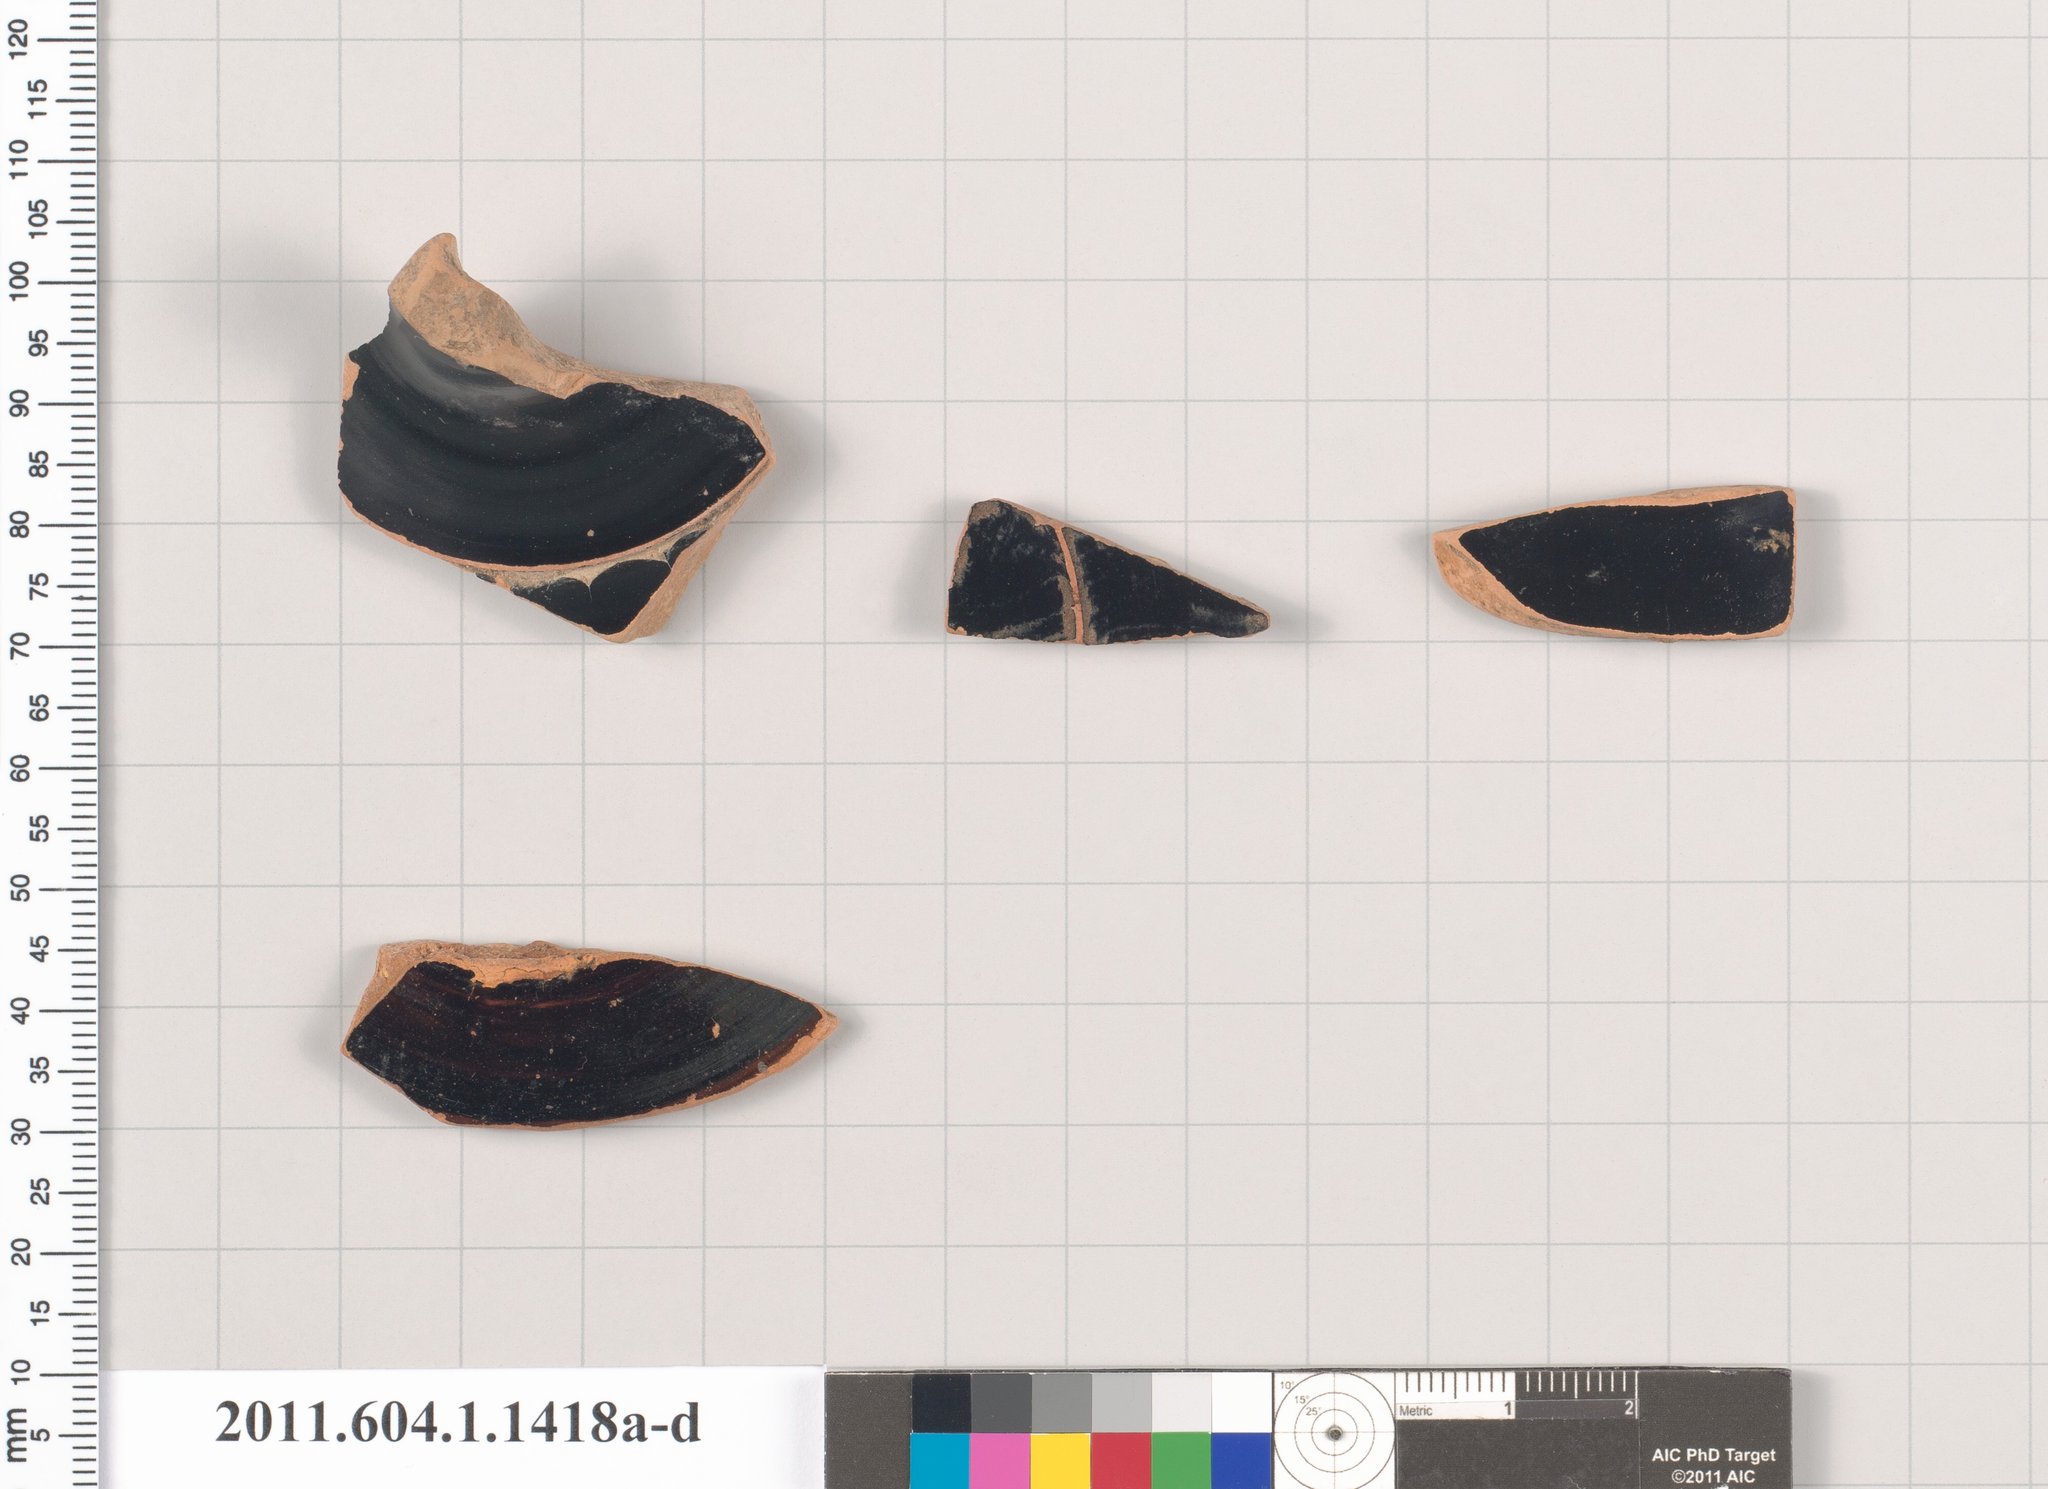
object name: kylix fragment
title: Terracotta fragments of kylikes (drinking cups)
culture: greek, attic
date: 500-401 BCE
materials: terracotta